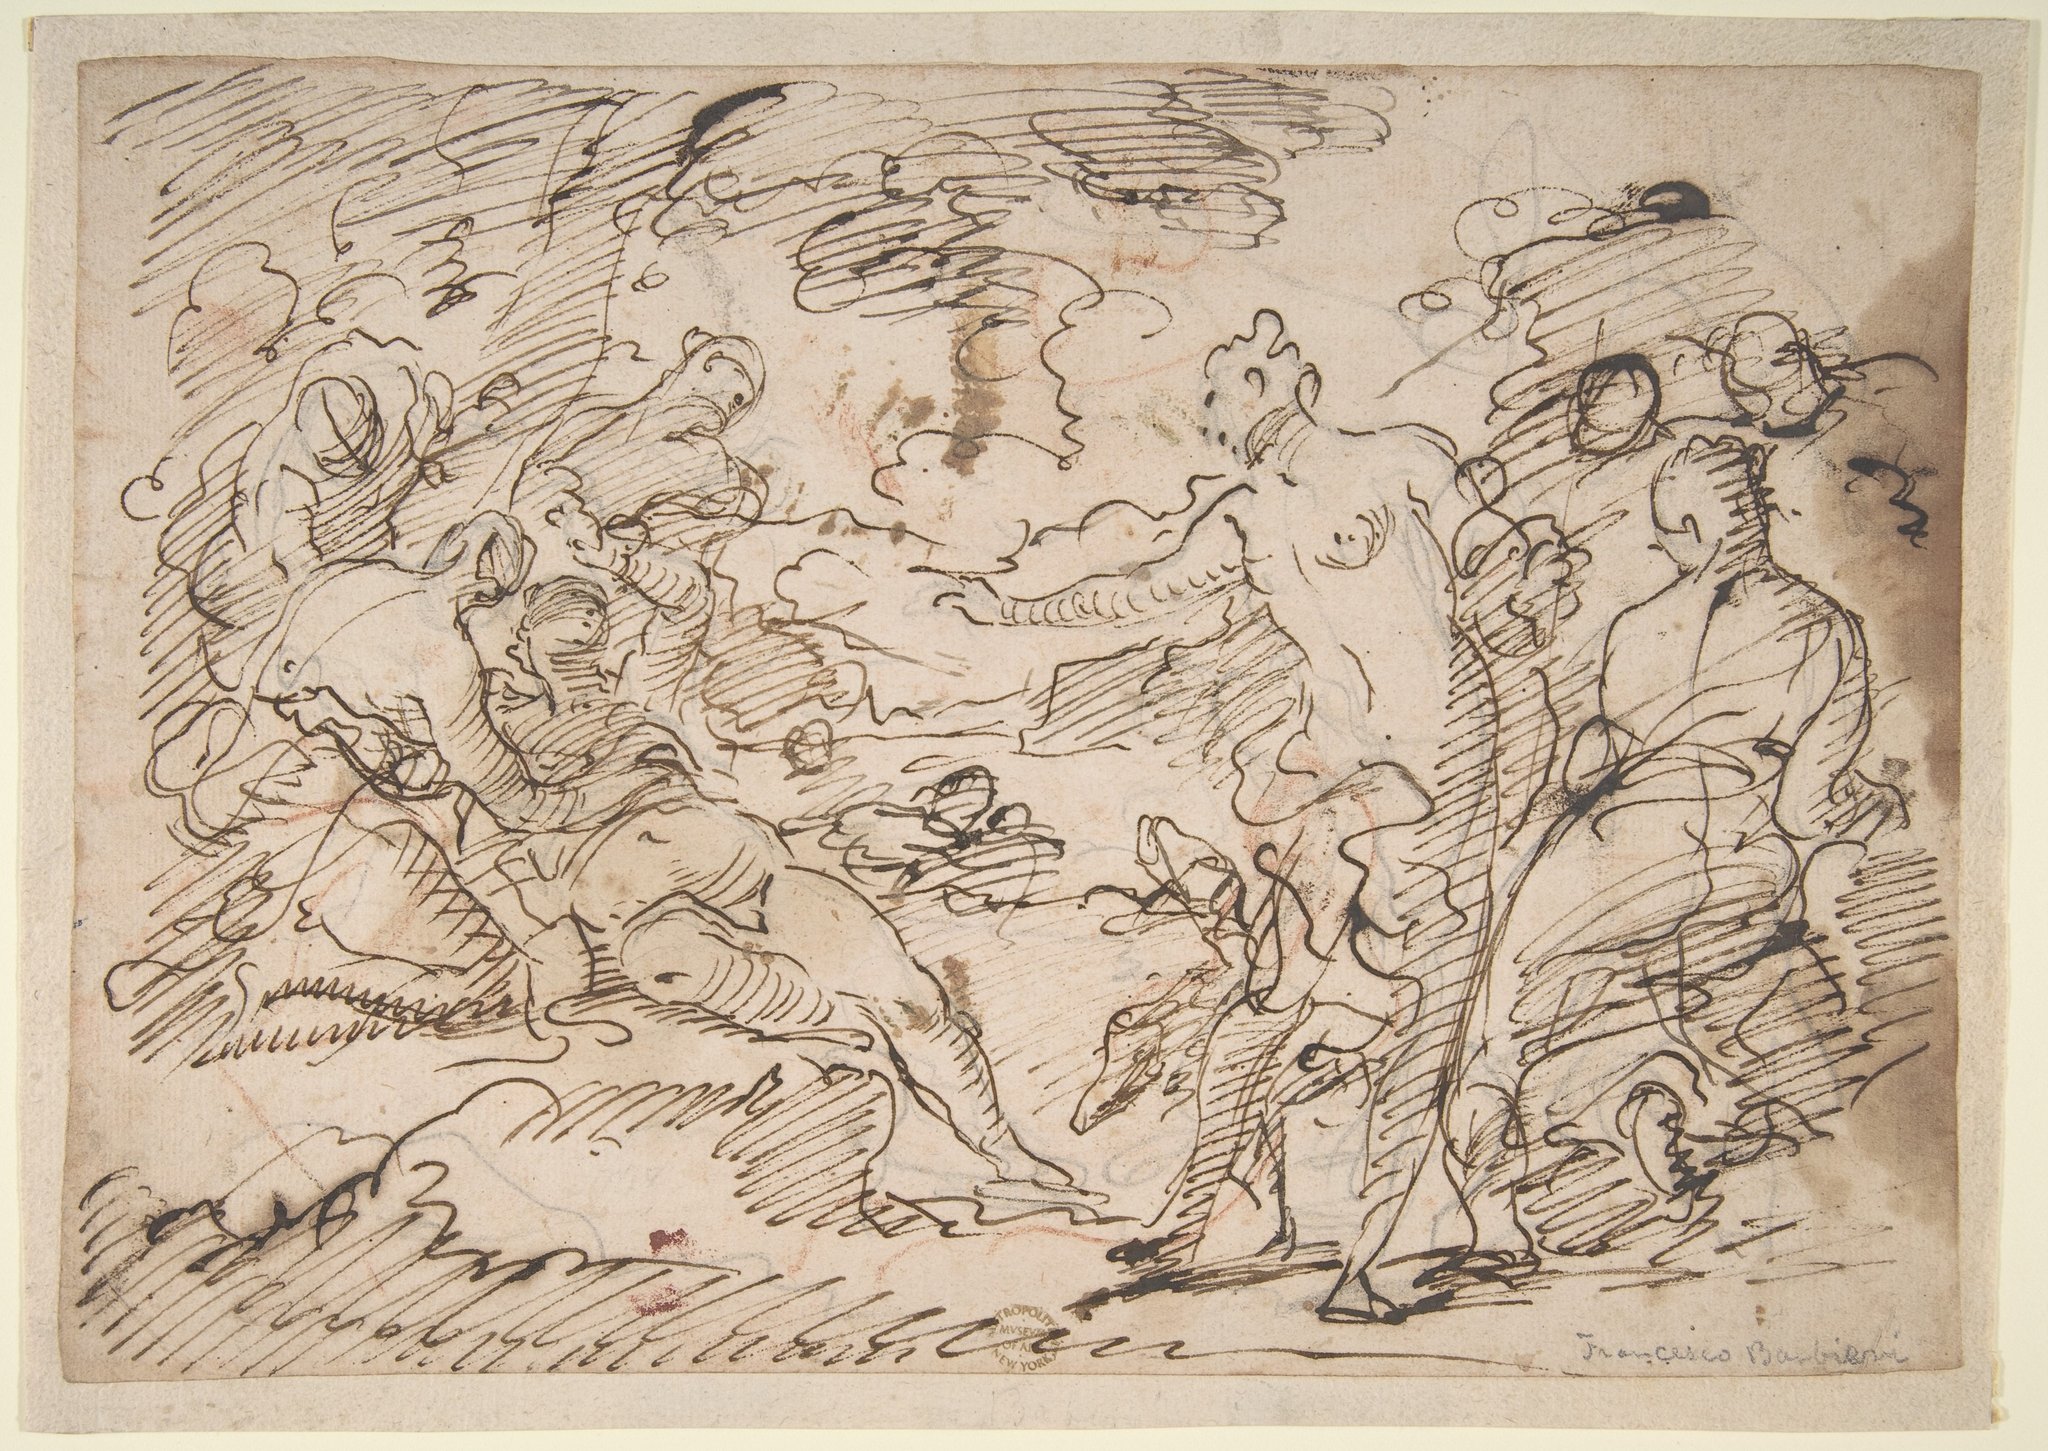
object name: drawing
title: The Pregnancy of Callisto Discovered by Diana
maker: antonio molinari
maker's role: artist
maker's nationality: italian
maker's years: 1655-1704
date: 1612-1666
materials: chalk, ink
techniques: pen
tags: human figures,nymphs,diana